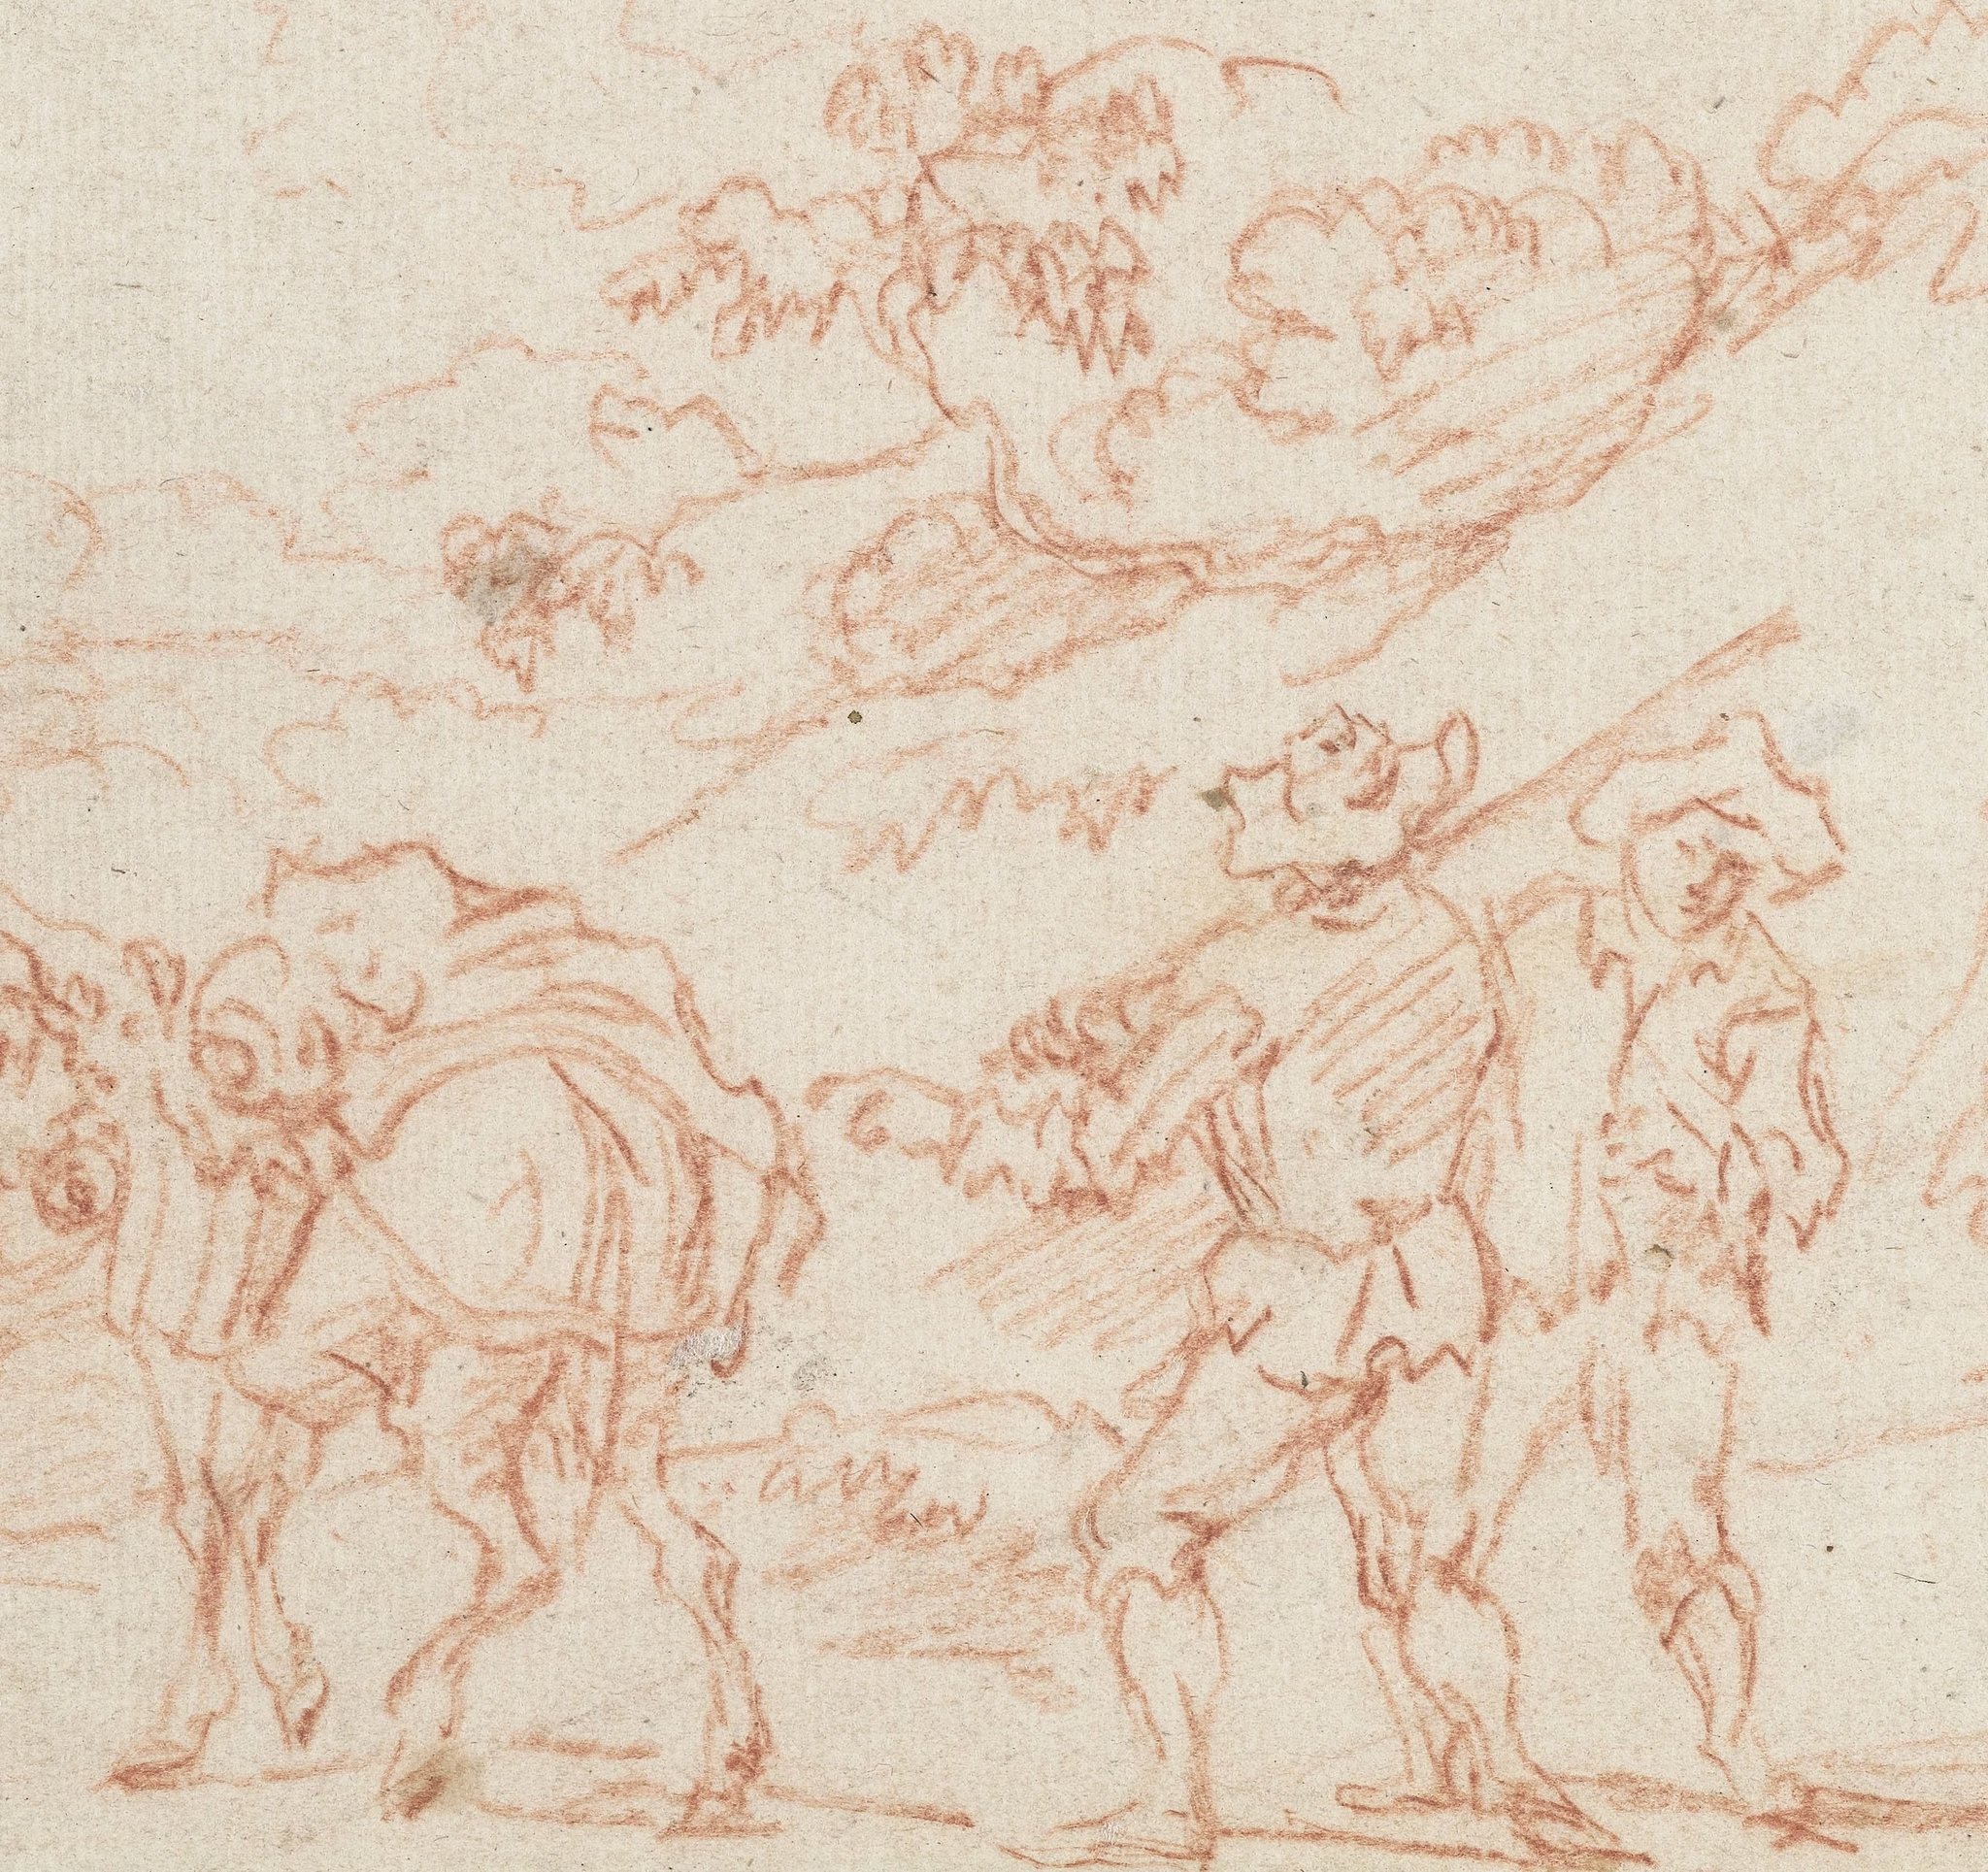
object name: drawing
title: Twee mannen achter een bepakte ezel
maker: nicolaes pietersz berchem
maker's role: draughtsman, print maker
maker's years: 1620-1683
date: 1630-1683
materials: chalk, paper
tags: ass, donkey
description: Twee mannen achter een bepakte ezel lopend, de een van voren, de ander op de rug te zien. Op de achtergrond een begroeide helling.